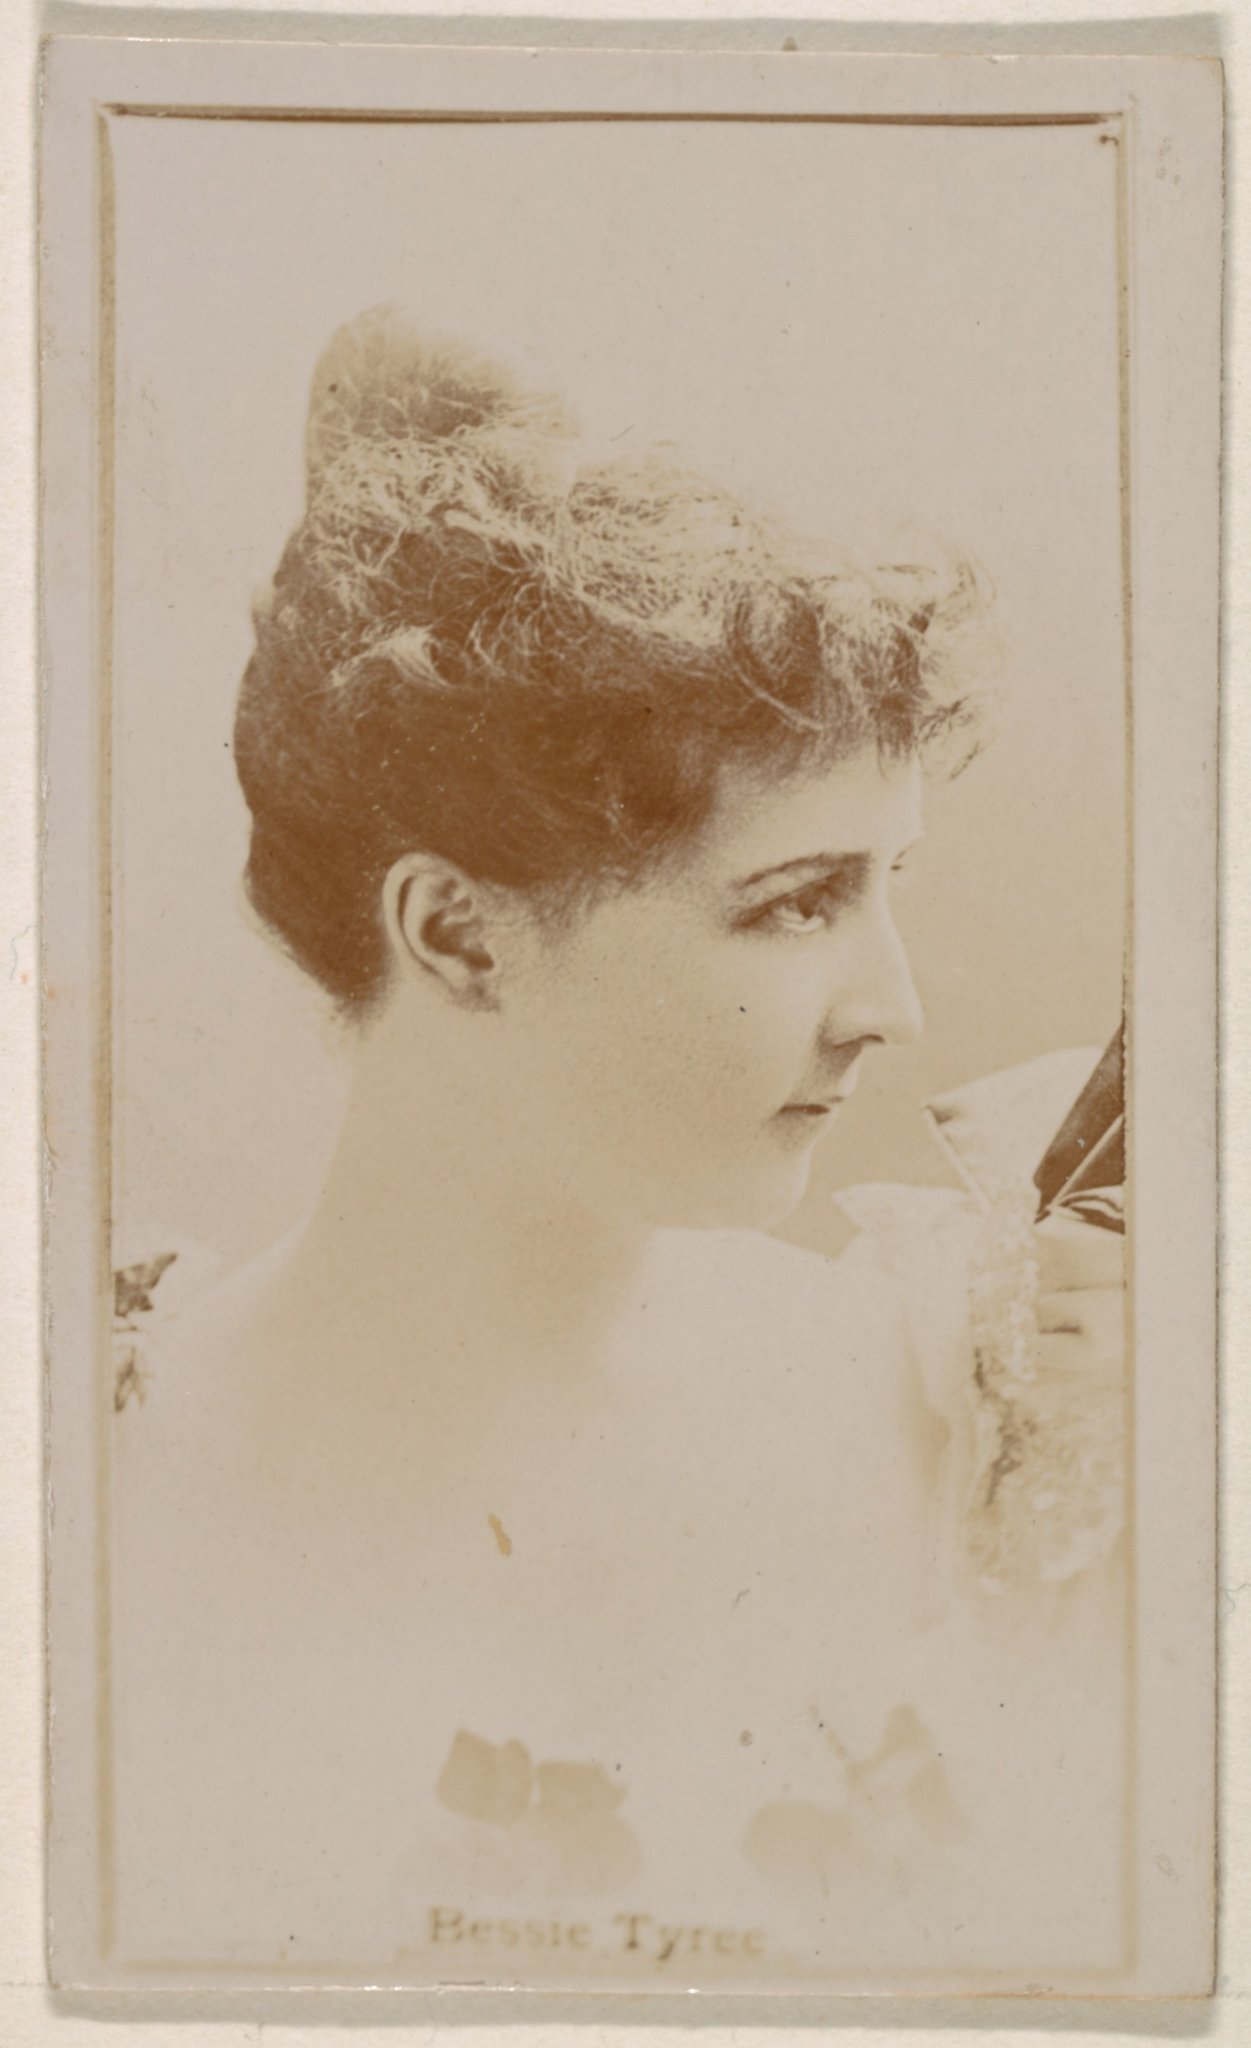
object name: photograph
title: Bessie Tyree, from the Actresses series (N245) issued by Kinney Brothers to promote Sweet Caporal Cigarettes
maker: kinney brothers tobacco company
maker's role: publisher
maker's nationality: american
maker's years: 1869-2011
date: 1890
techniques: albumen silver print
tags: women,actresses